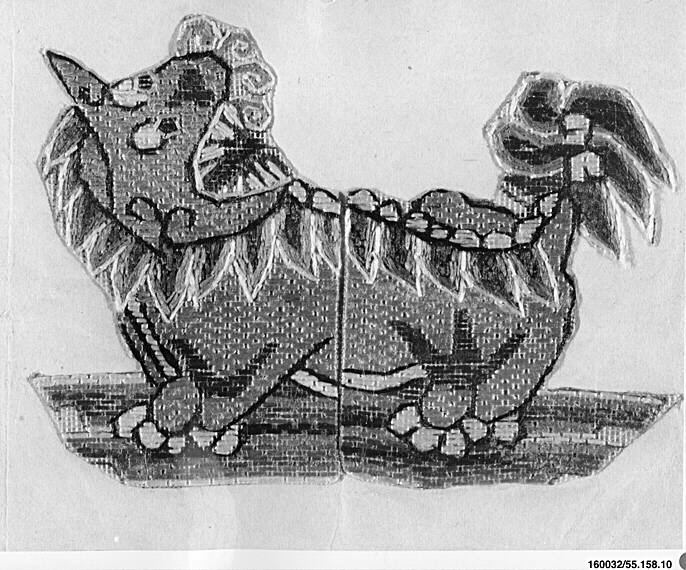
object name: appliqué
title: Applique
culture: chinese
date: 1867-1933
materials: silk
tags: animals